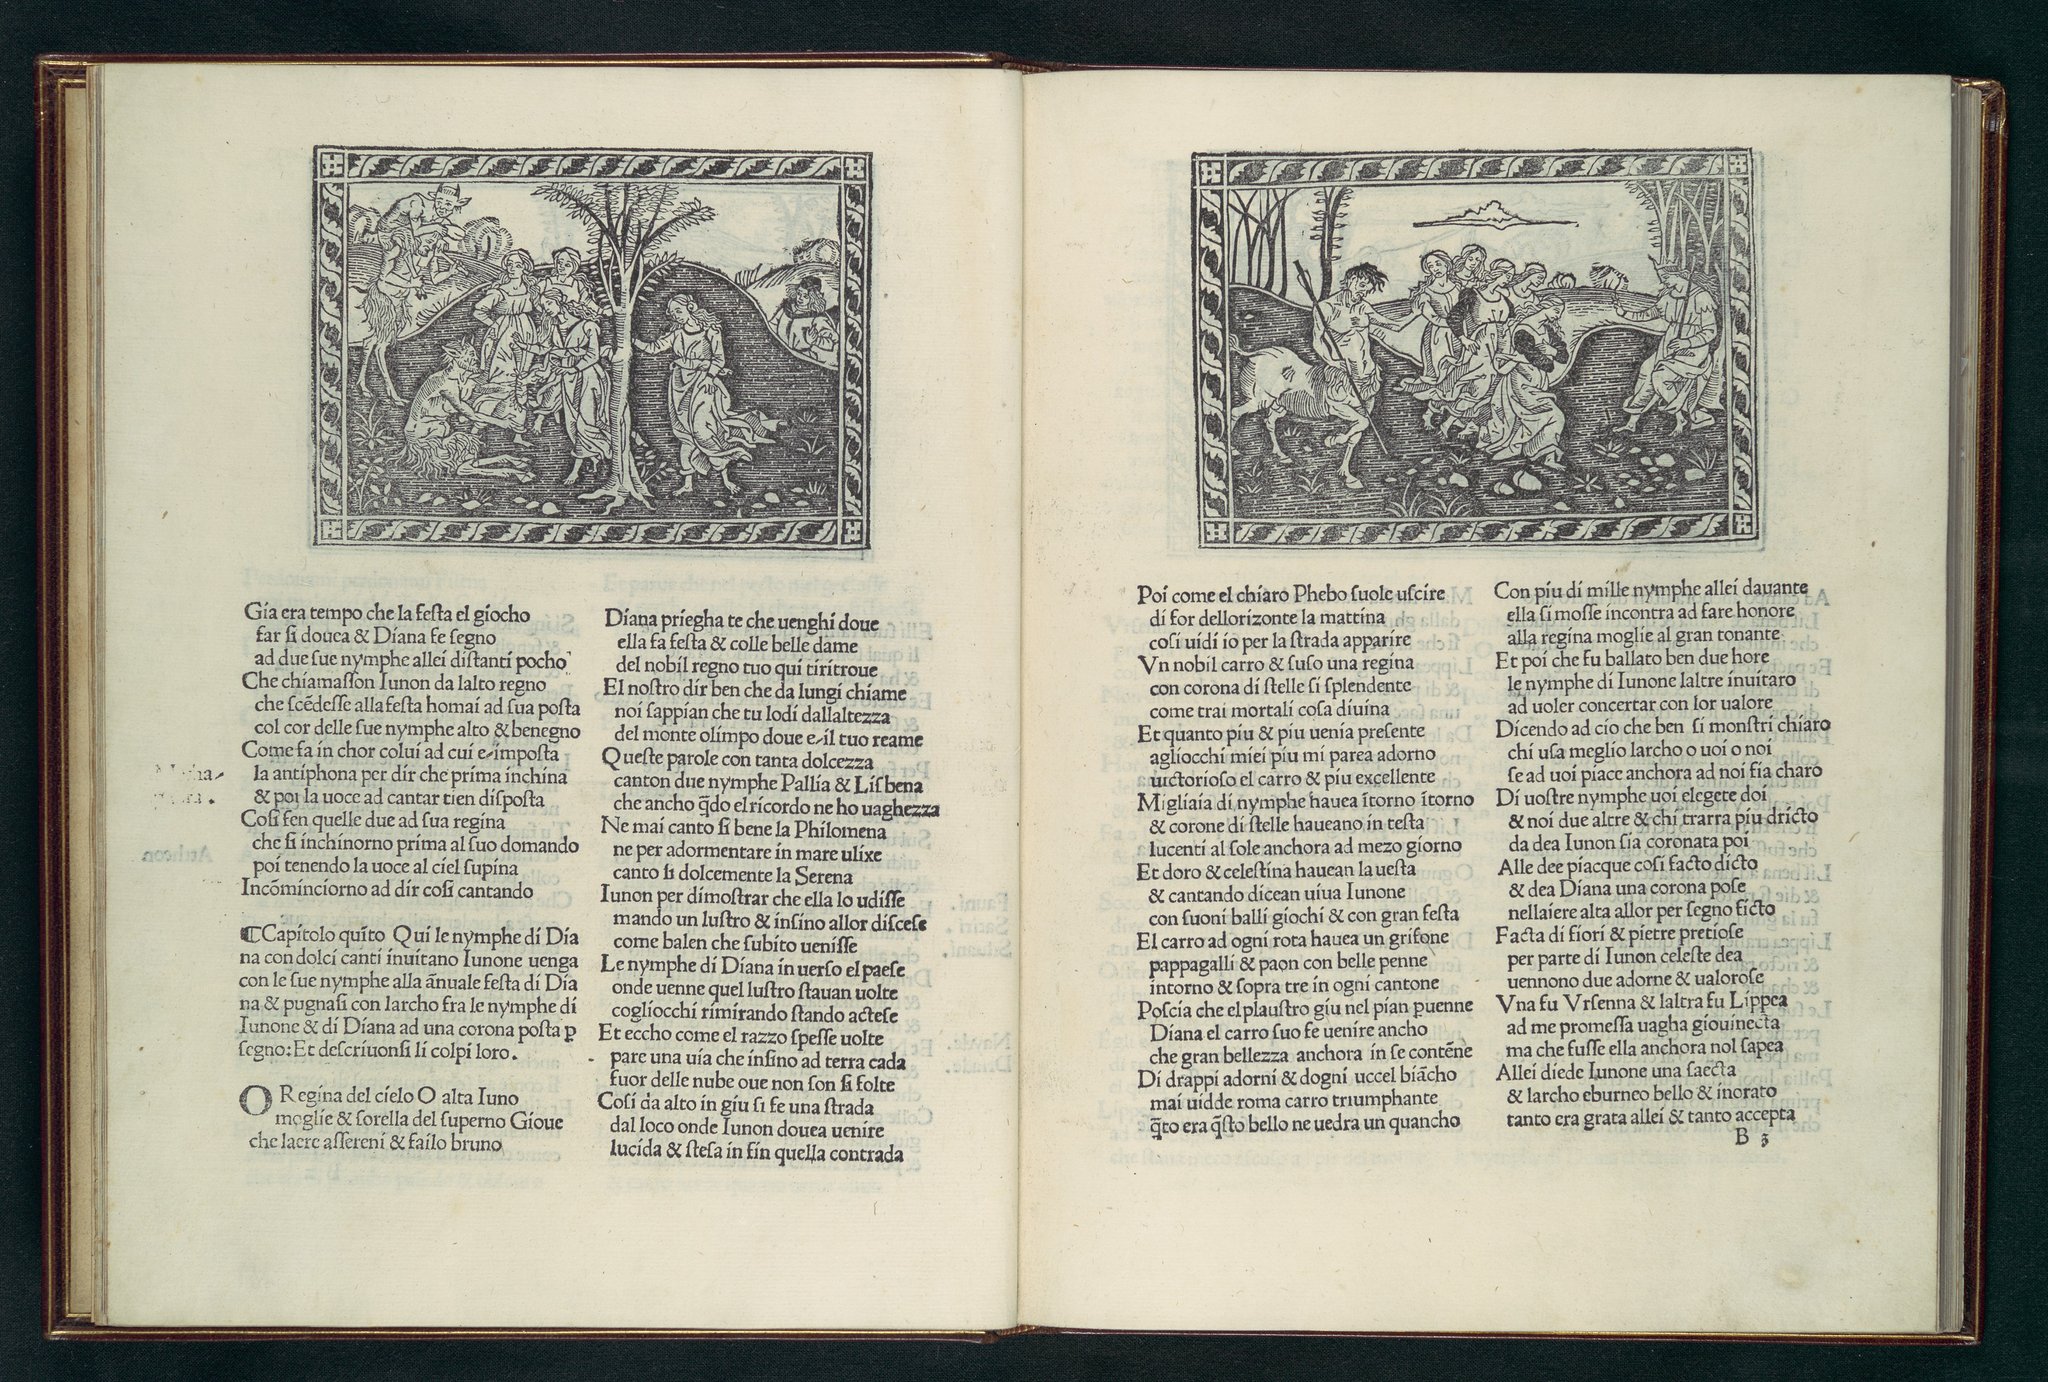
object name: book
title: Quatriregio (Four Realms)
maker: federico frezzi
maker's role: author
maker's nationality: italian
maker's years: 1346-1416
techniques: printing, woodcut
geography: italy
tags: centaurs,nymphs,diana,satyrs